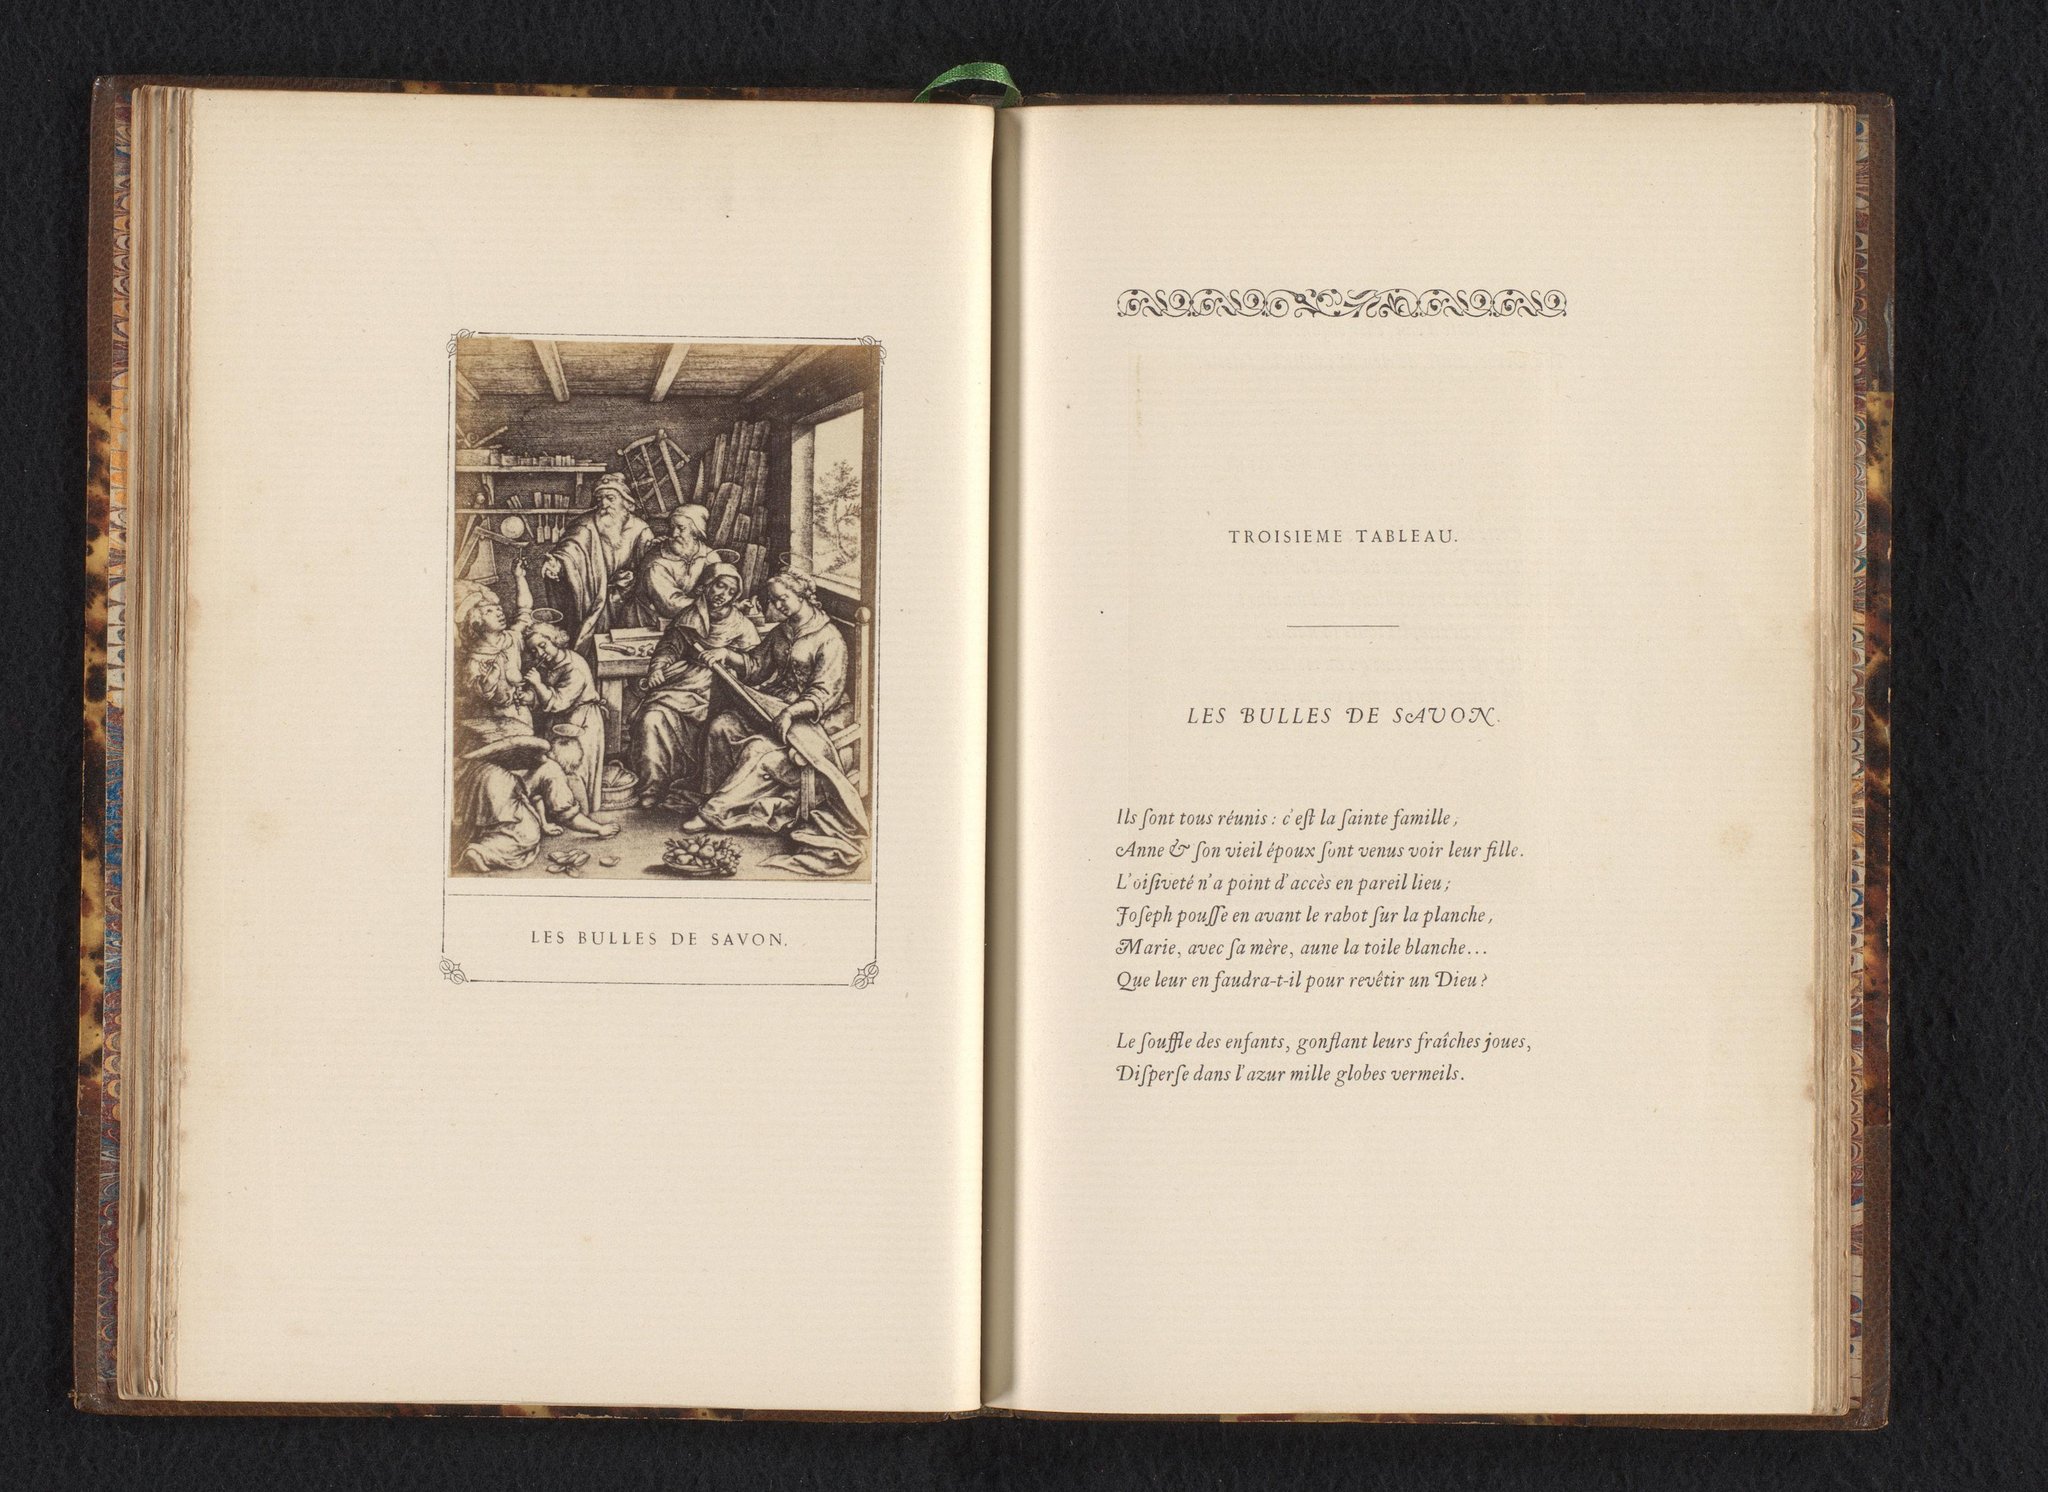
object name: page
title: Fotoreproductie van de gravure Les bulles de savon door Hieronymus Wierix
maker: edmond fierlants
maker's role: fotograaf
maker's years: 1819-1869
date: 1855-1860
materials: paper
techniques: albumen print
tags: bubble-blowing (children's games and plays), workshop-interior